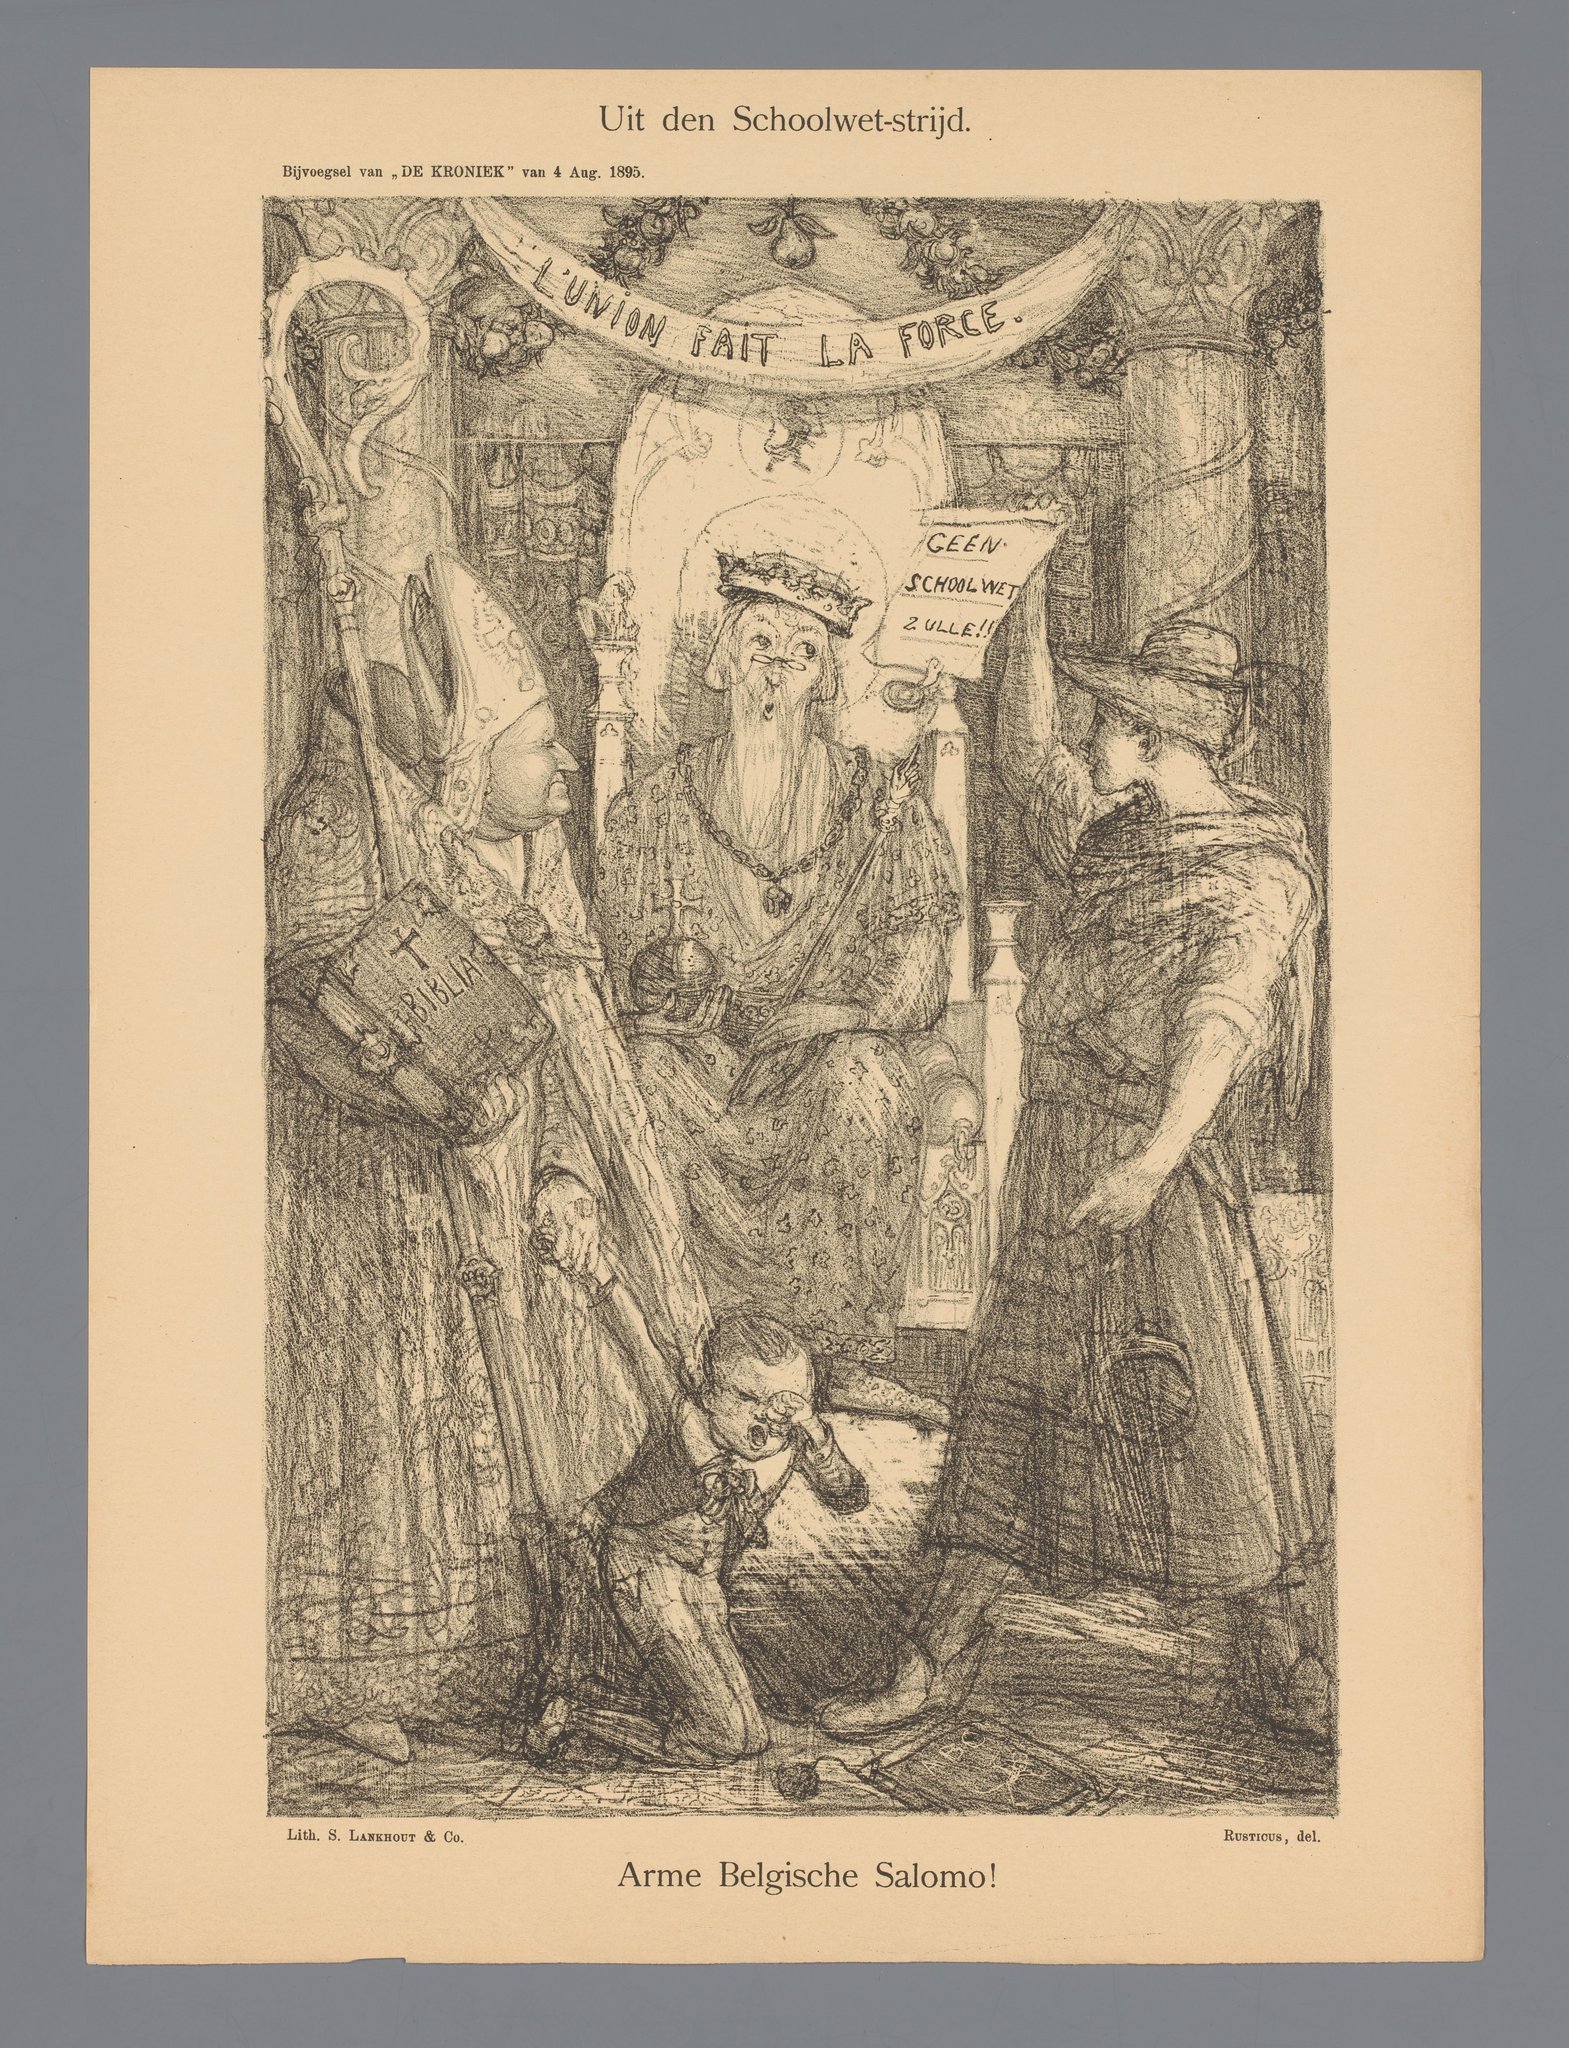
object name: cartoon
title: Uit den Schoolwet-strijd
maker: marius bauer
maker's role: draughtsman, print maker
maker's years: 1867-1932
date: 1895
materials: paper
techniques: lithograph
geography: the hague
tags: hierarchy of jurisdiction ~ roman catholic church, scholastic education, tuition, king, political caricatures and satires, belgium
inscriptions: date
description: Spotprent op de schoolstrijd in België in 1895. Pastiche op het oordeel van koning Salomo die moet kiezen tussen de kerk als voorstander en de liberale tegenstander van de schoolwet, in het midden een huilend schoolkind